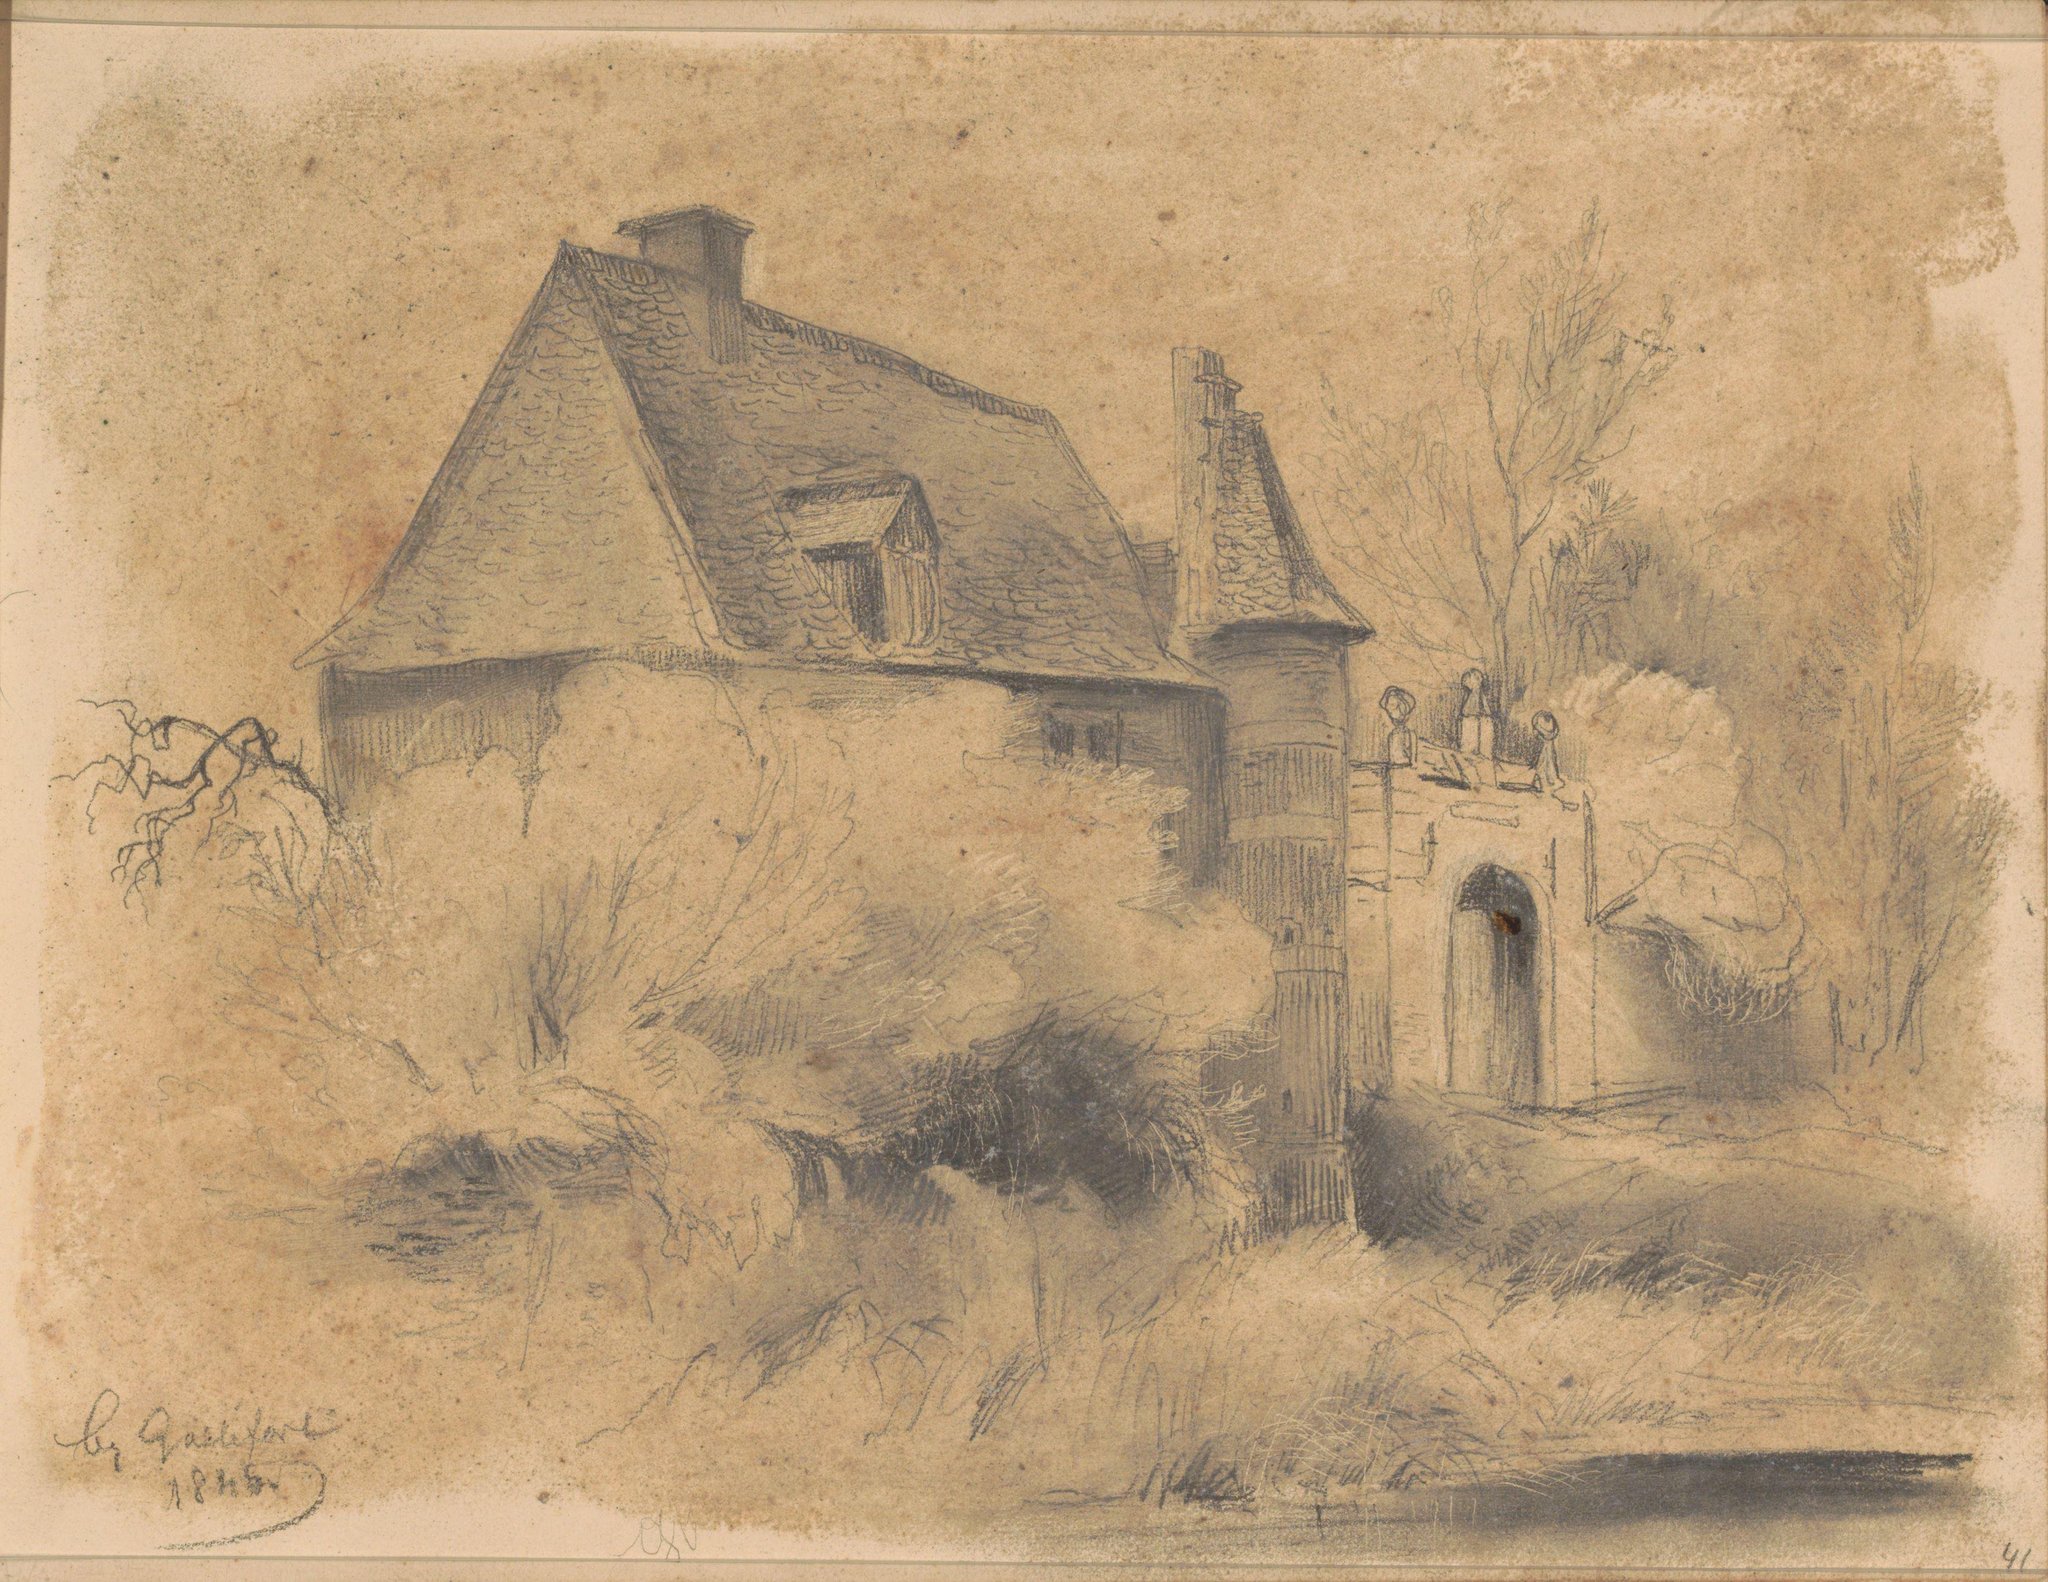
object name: sketchbook leaf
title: Huis met een torenspits bij Gallifort nabij Antwerpen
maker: johannes tavenraat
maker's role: draughtsman, painter, print maker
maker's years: 1809-1881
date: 1845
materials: chalk, paper, pencil, watercolor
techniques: brush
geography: antwerp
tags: rural housing, e.g. country-house, villa, cottage, tower (of house or building)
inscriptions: date and inscription: ‘bij Gallifort/ 1845’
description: Blad 41 recto uit een schetsboek met 43 bladen.